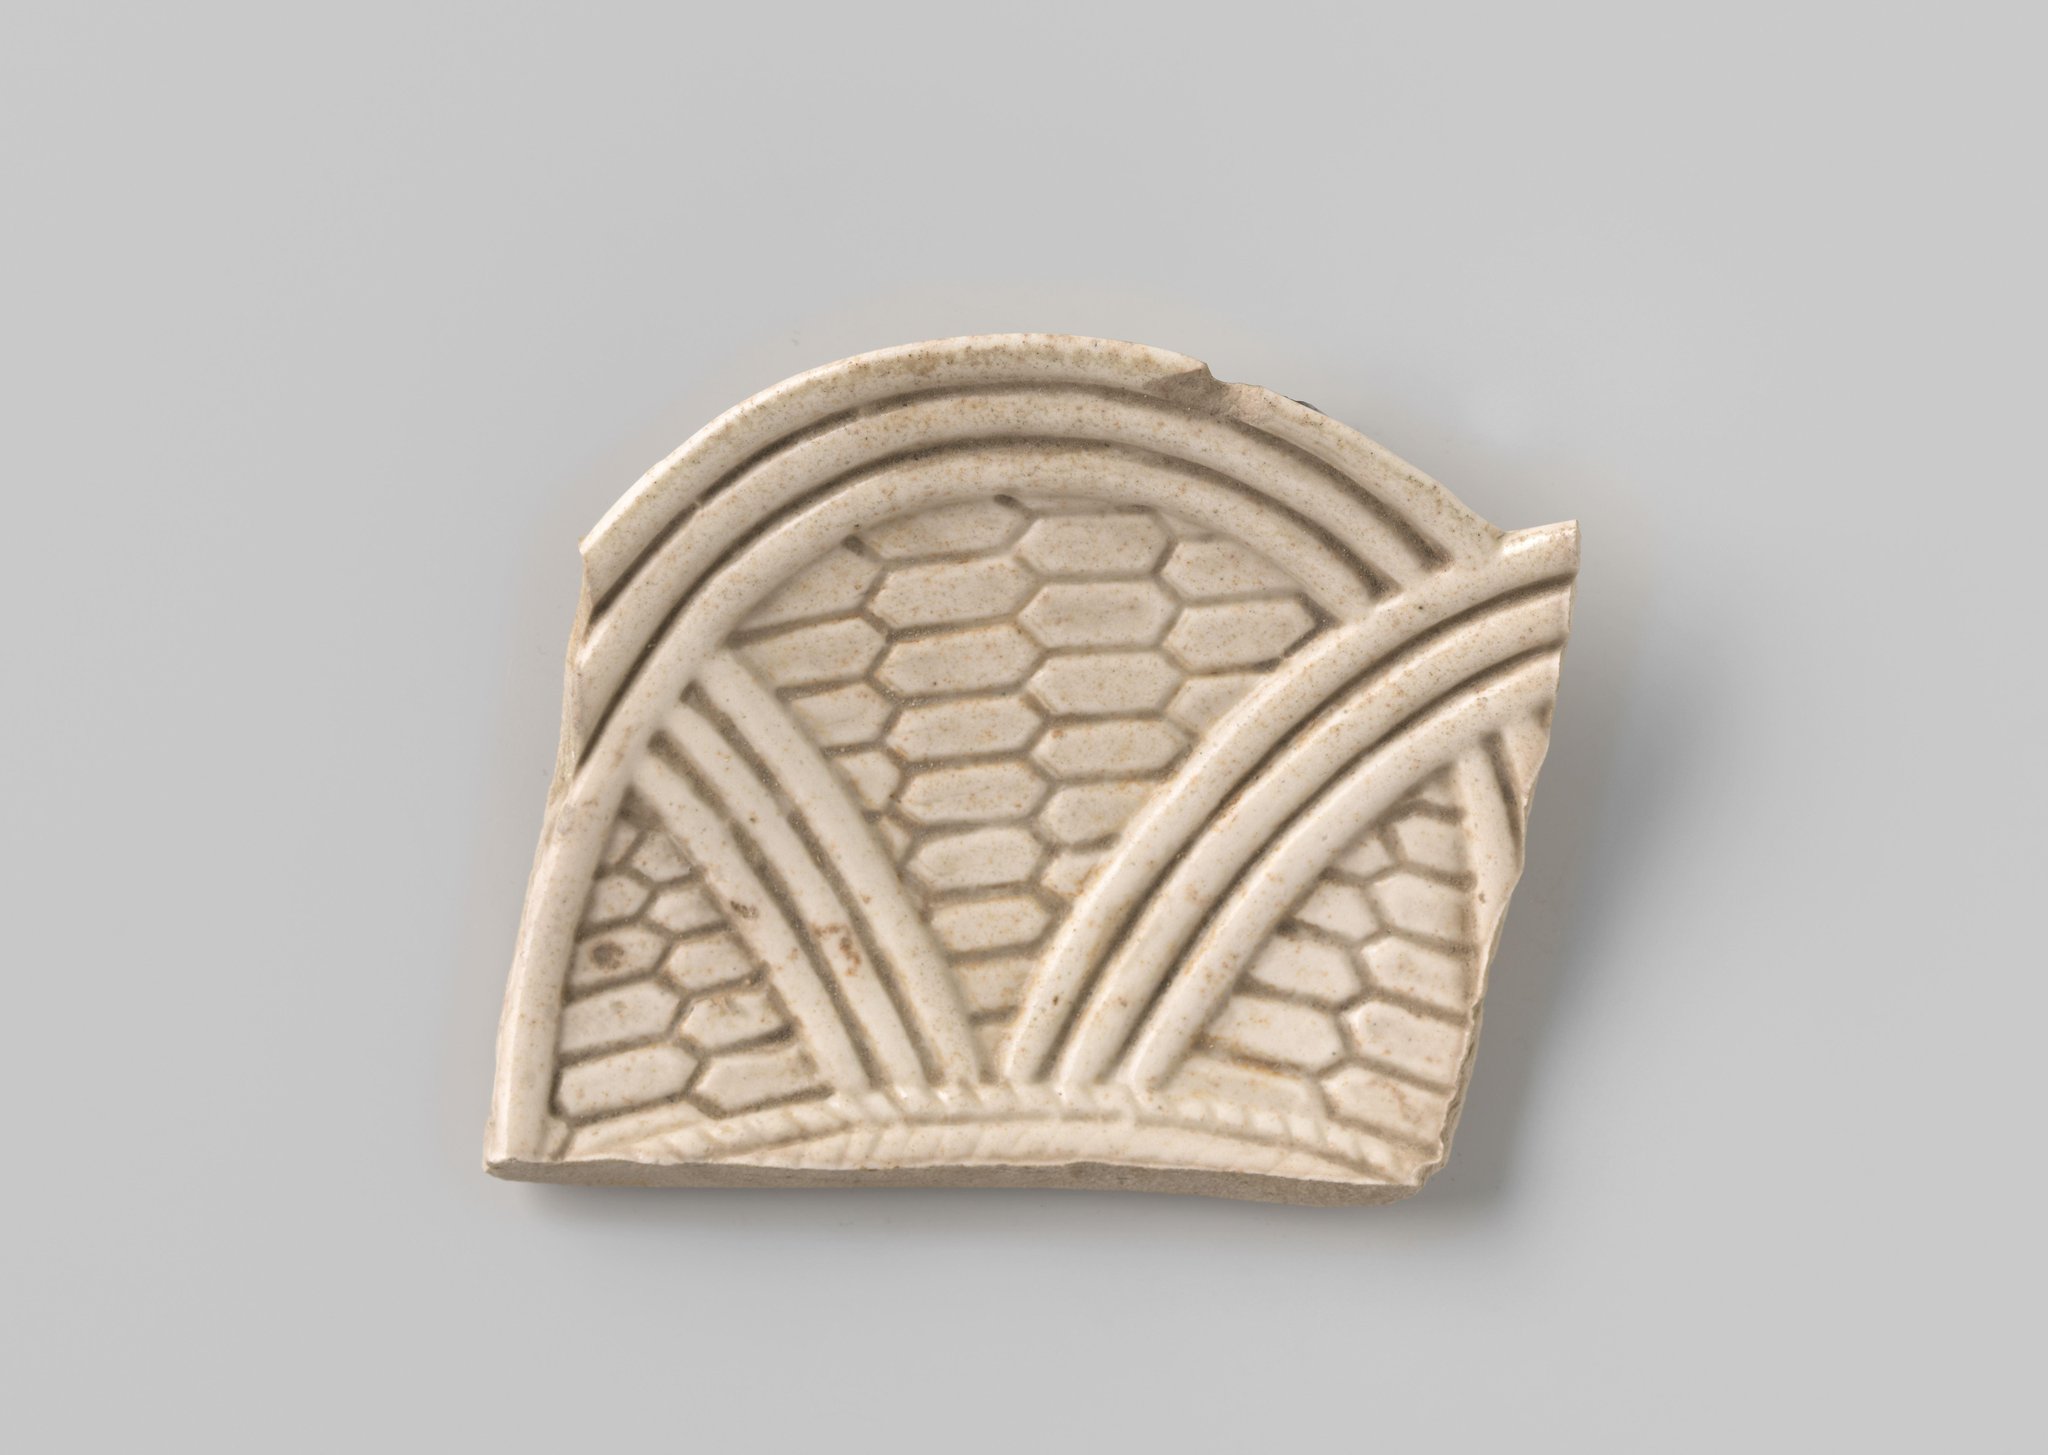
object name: sherd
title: Sherd with arches in reliëf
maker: Anonymous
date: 1500-1799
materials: glaze, stoneware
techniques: firing, relief, turning, vitrification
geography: germany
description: Scherf van aardewerk of van porselein uit een serie van elf stuks. Opgegraven in het terrein tussen Amstel en Schinkel.